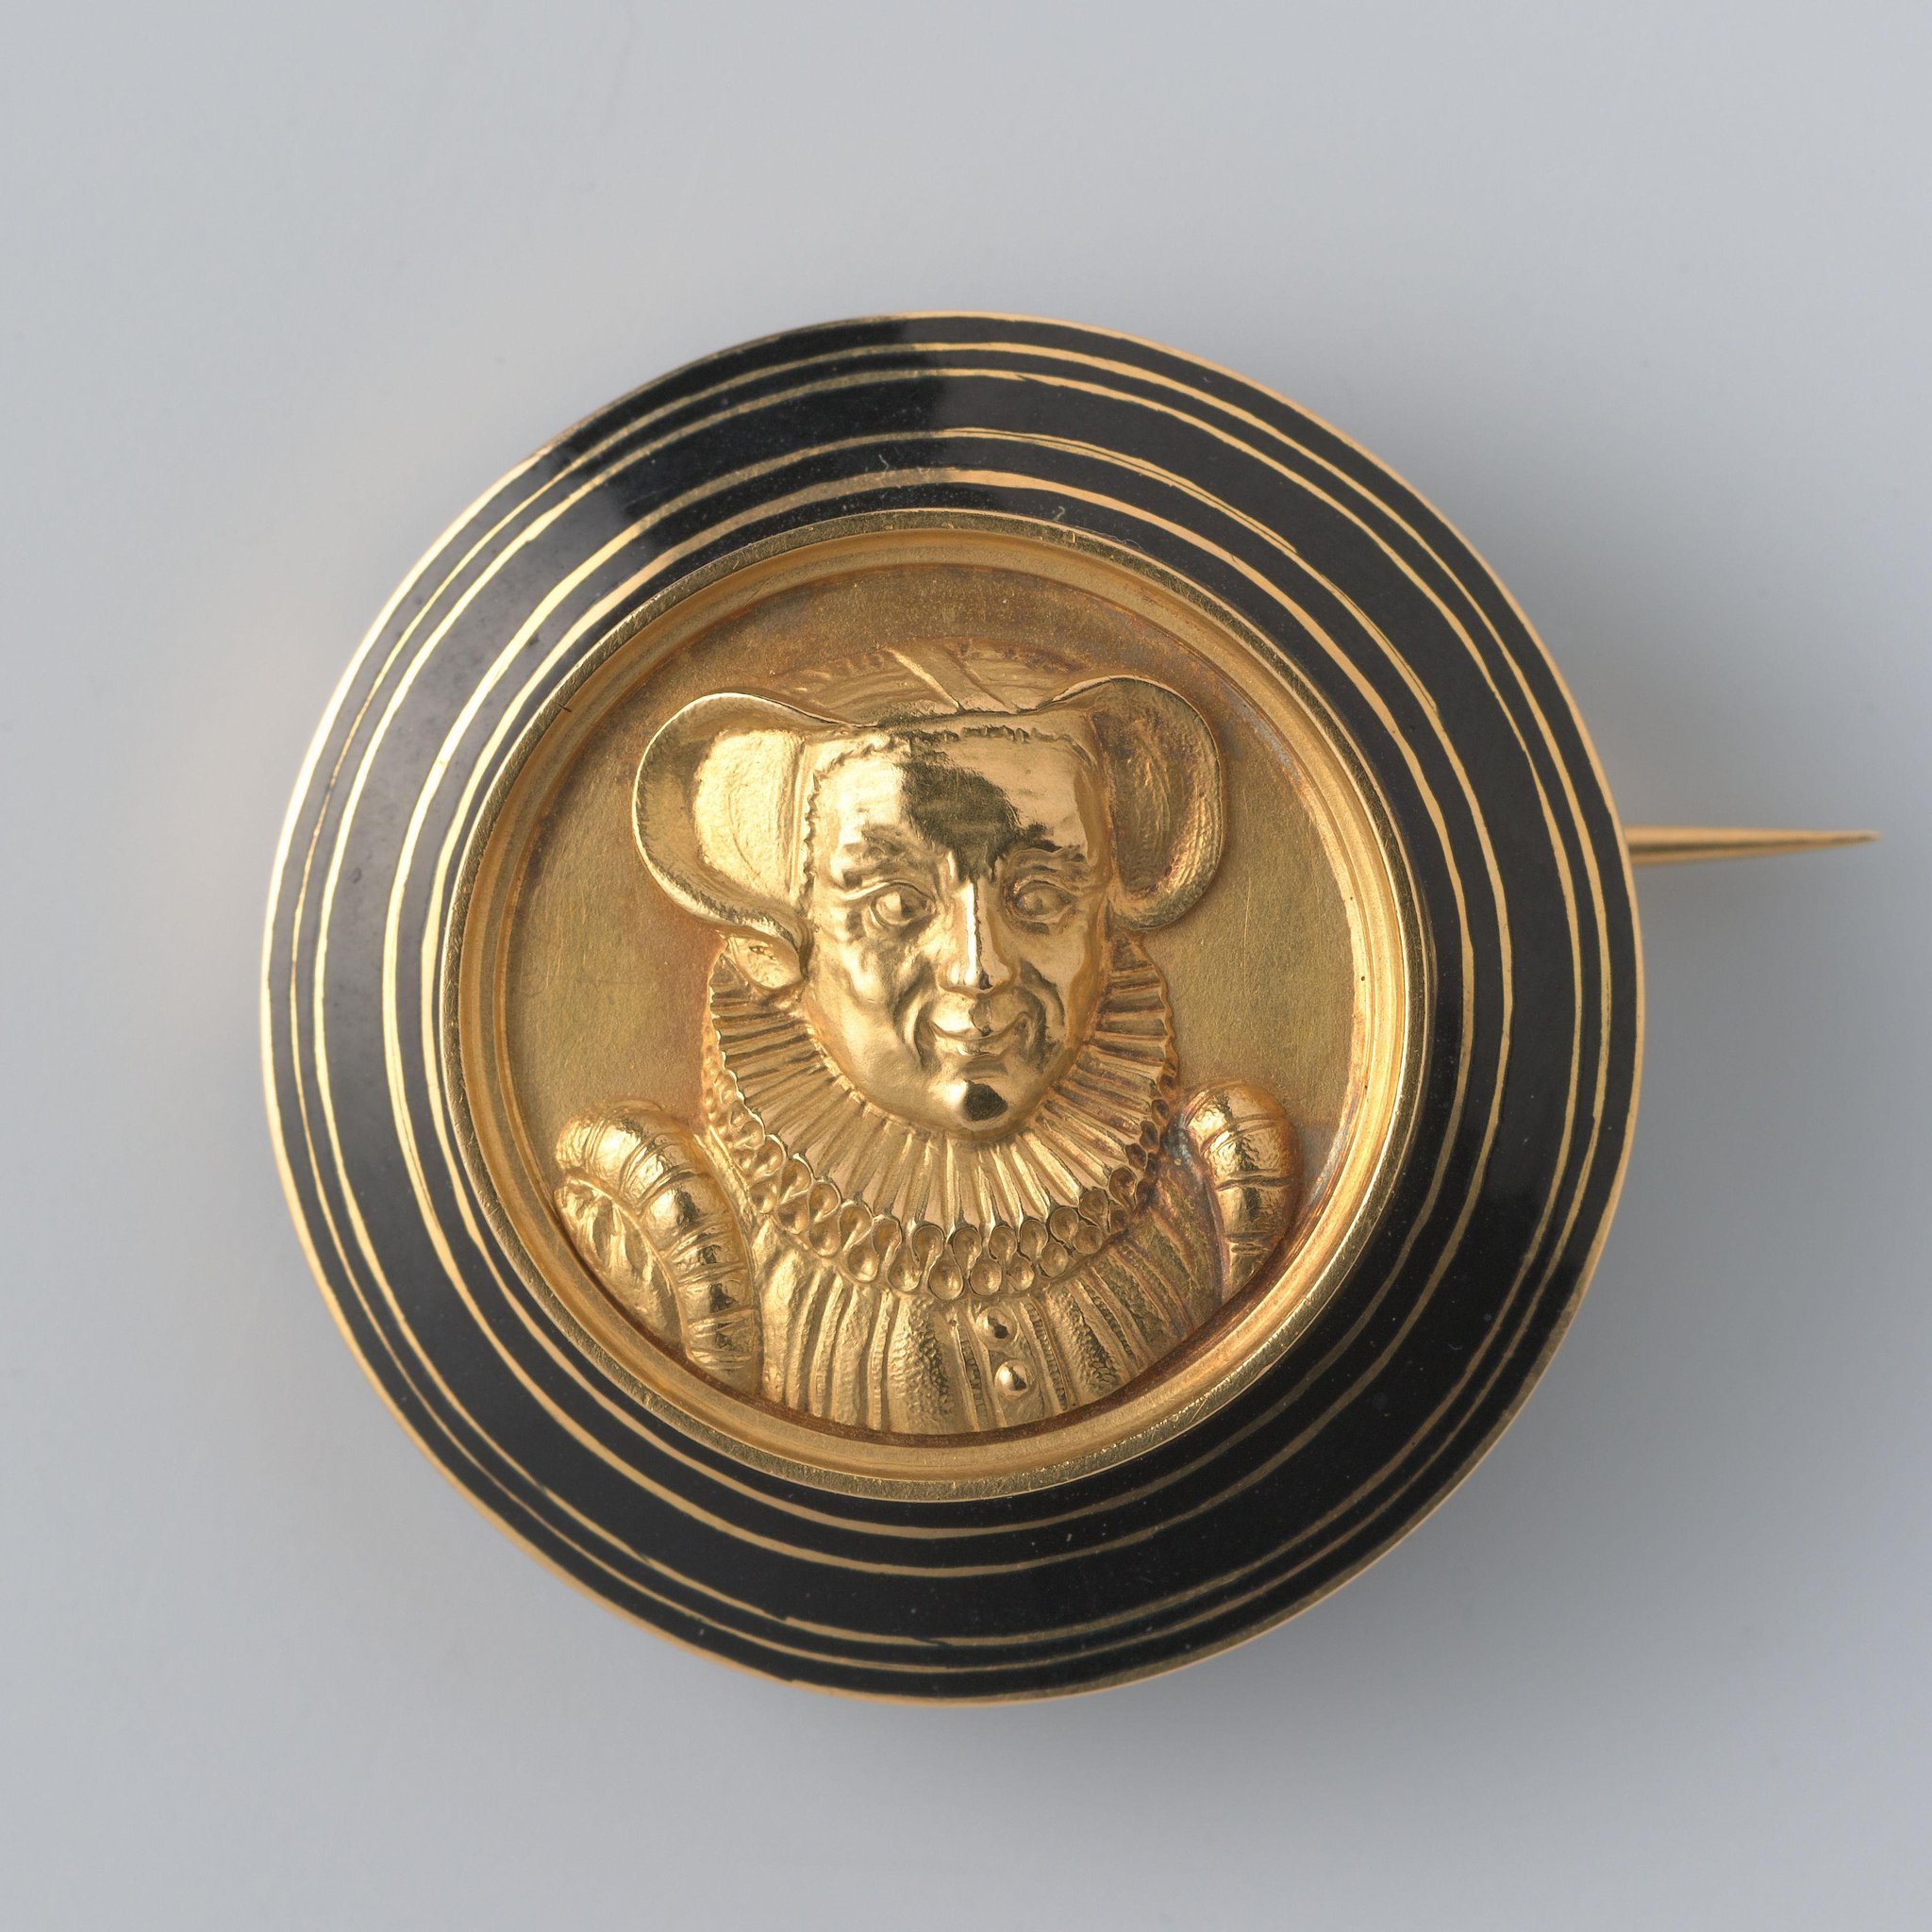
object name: jewellery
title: Parure (set of matching jewellery)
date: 1854-1858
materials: gold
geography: voorschoten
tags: maria van utrecht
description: The writer and journalist E.J. Potgieter was among the first in the 19th century to devote attention to women from the past. He commissioned this jewellery set as a gift for a relative. The seven depicted Dutch women symbolize decisiveness and fortitude. Potgieter believed his lethargic countrymen could learn a lesson from them. The medallion contains a photograph of Potgieter and a lock of his hair.